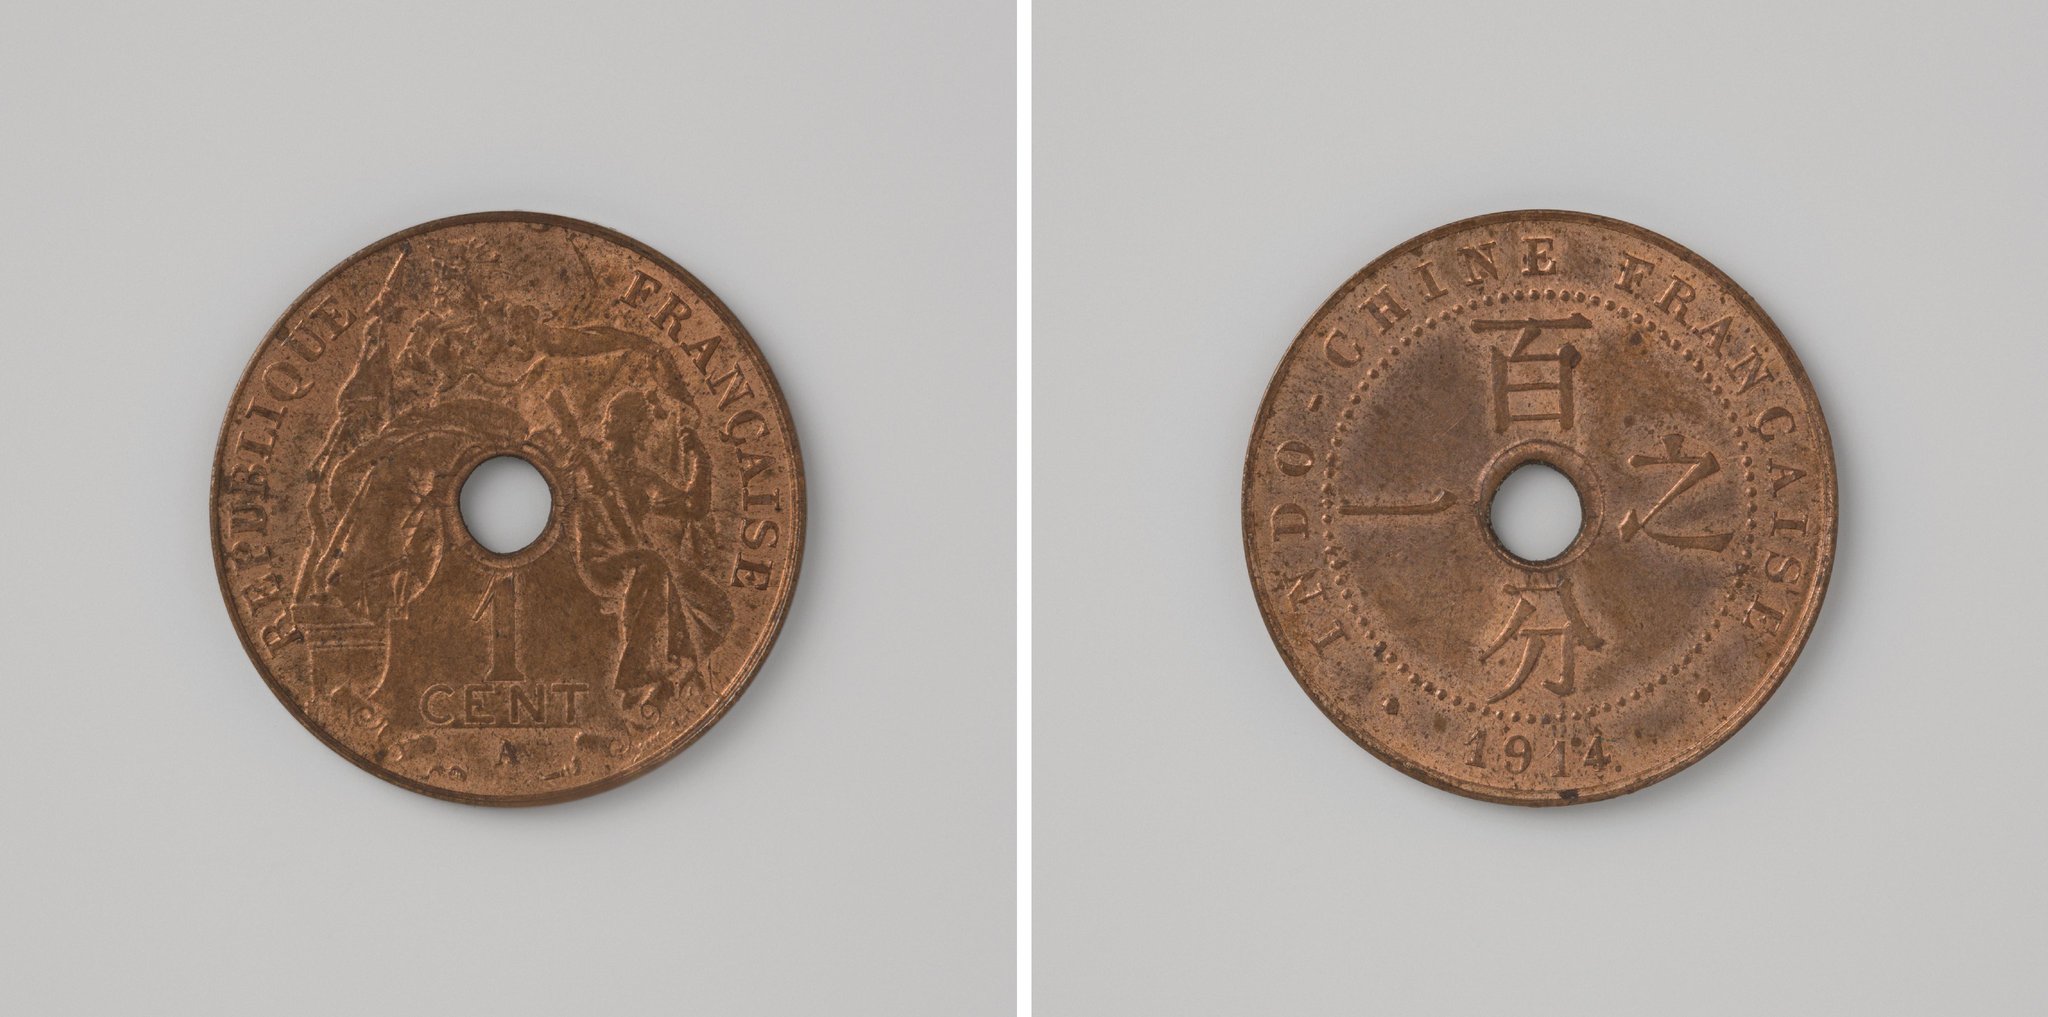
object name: centime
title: Centime uit Frans Indo-China, 1914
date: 1914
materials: bronze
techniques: striking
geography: paris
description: Bronzen munt. Voorzijde: rondom ronde uitsparing allegorische voorstelling. Daartussen in twee regels waarde-aanduiding: 1 Cent. Daaronder letter A [=Parijs]. Keerzijde: rondom ronde uitsparing in het midden vier Chinese tekens, waaronder door liggend streepje aangegeven waarde-aanduiding: 1. Jaartal in omschrift onderaan. Gladde rand.